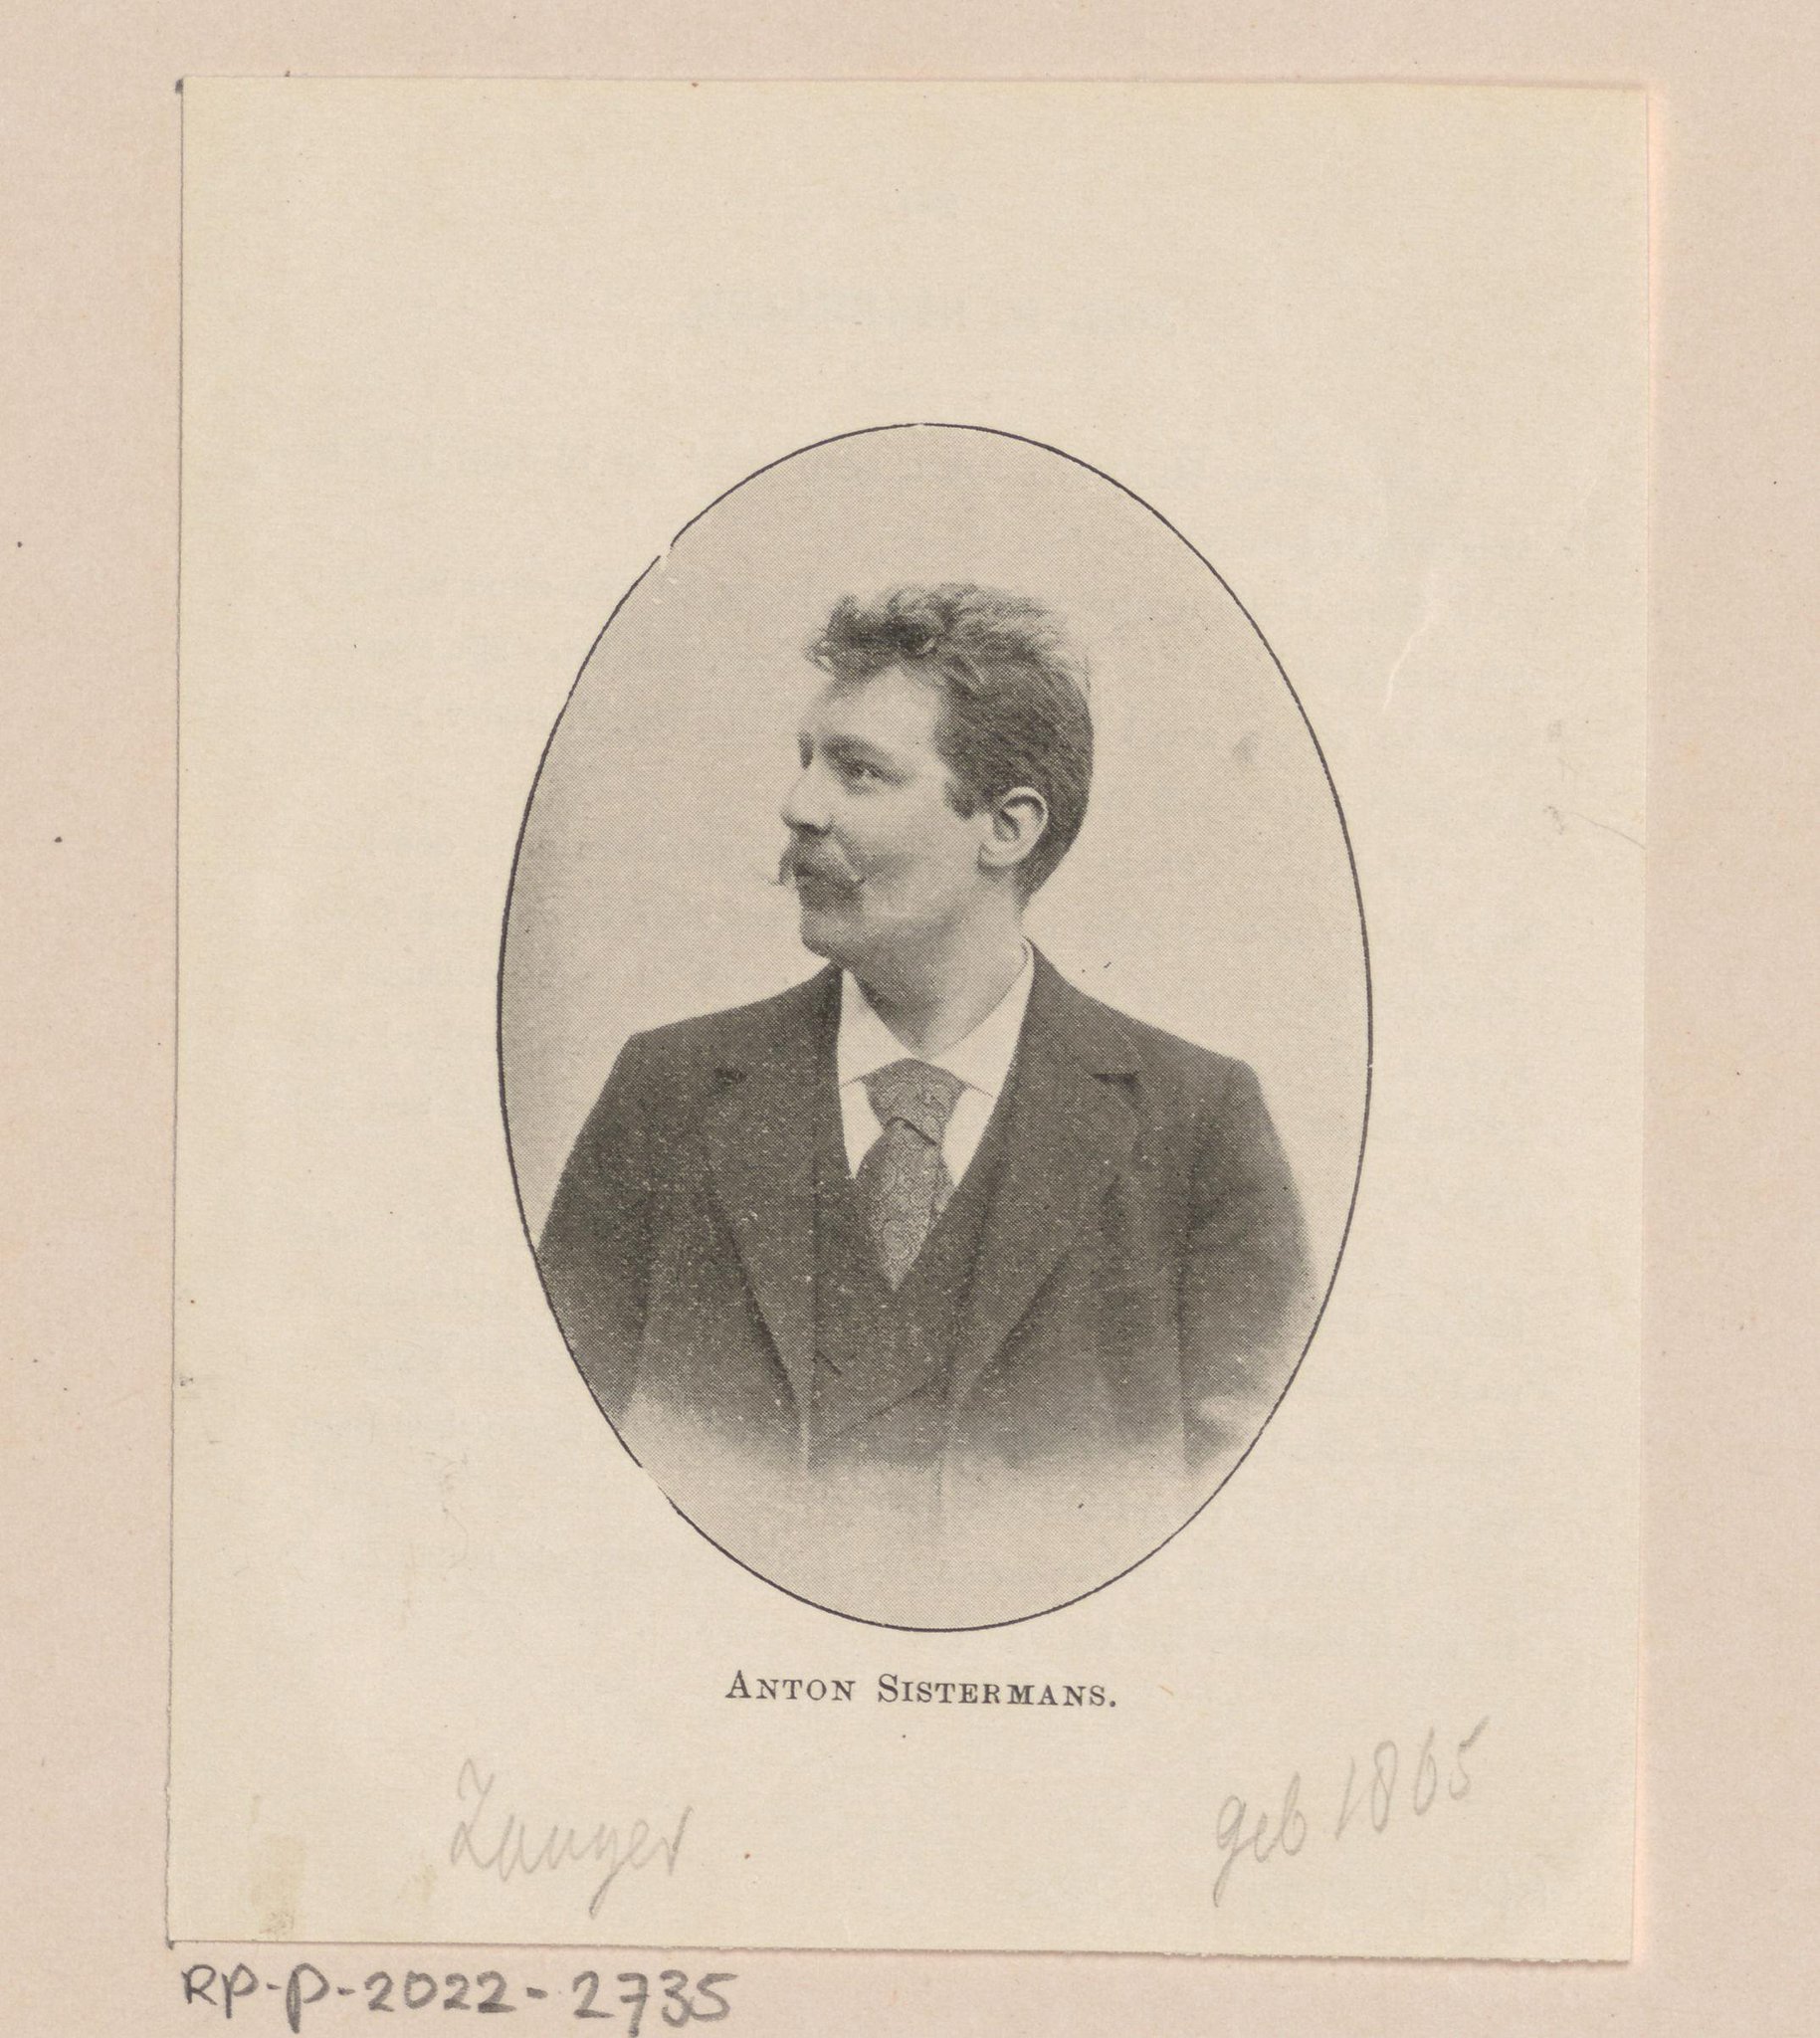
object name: photomechanical print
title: Portret van Anton Sistermans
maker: Anonymous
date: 1895-1970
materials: paper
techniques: autotype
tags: den bosch, historical persons, opera-singer (male)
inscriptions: inscription: ‘Zanger / geb 1865’